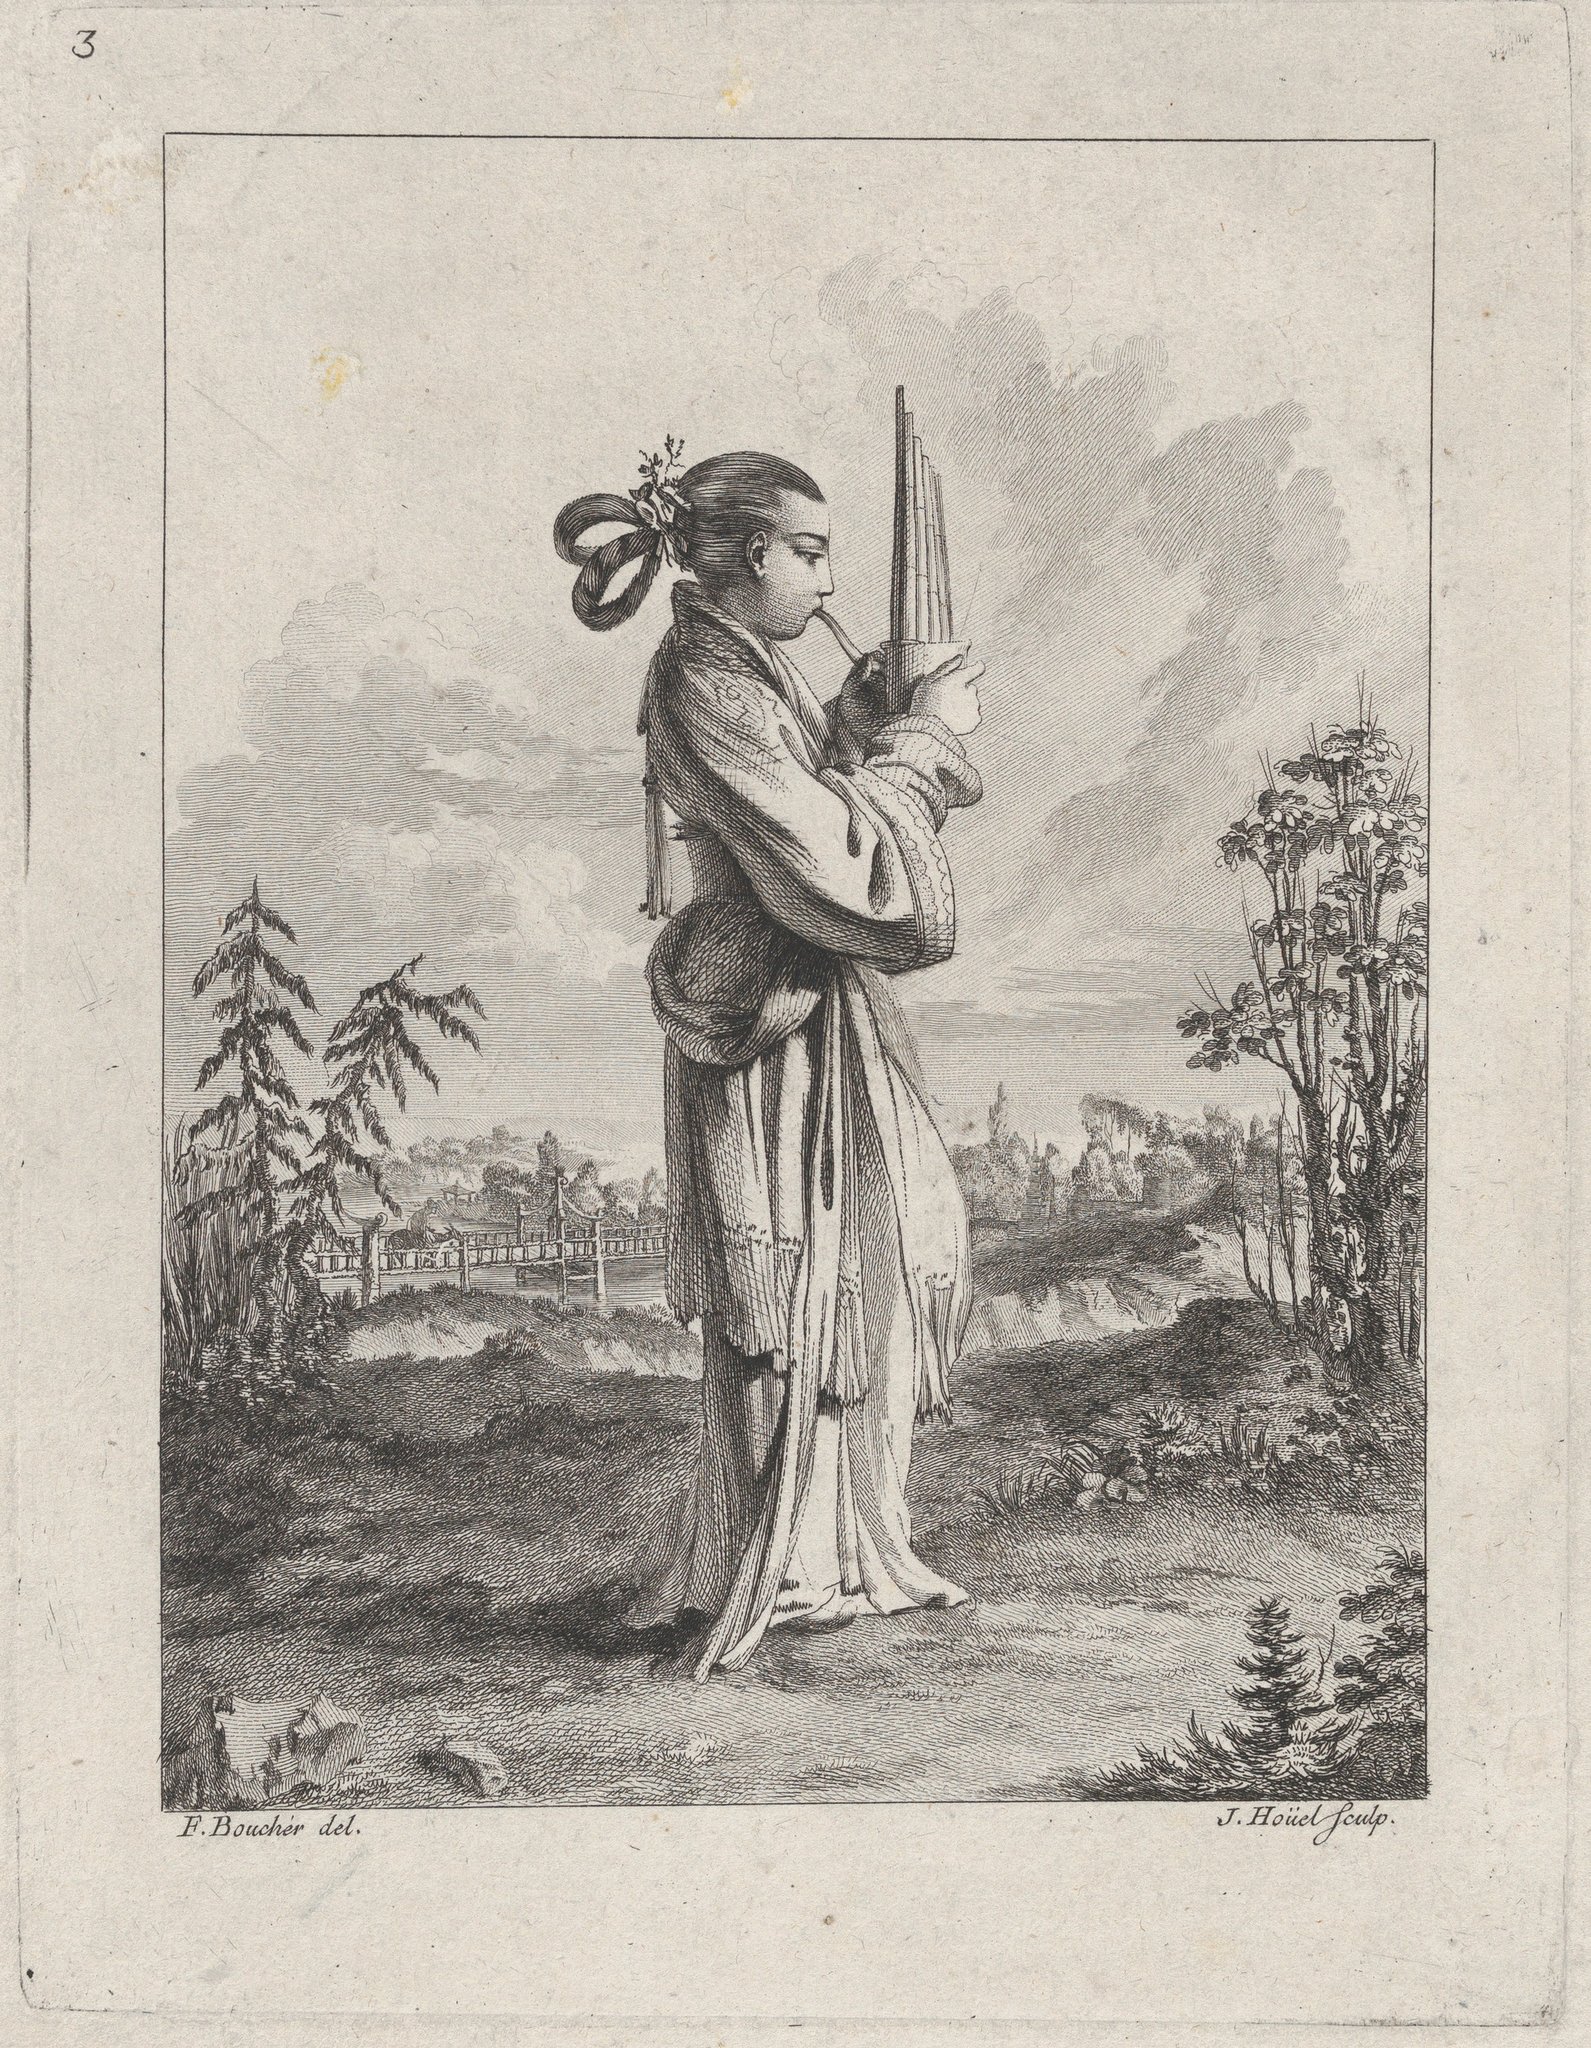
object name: print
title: Chinoiserie with a woman playing the mouth organ, from Suite de Figures Chinoises. . .Tiré du Cabinet de Mr. d'Azaincourt (Series of Chinoiserie Figures. . .From the Chambers of Mr. d'Azaincourt), plate 3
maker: jean pierre louis laurent hoüel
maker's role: artist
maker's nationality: french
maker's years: 1735-1813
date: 1755-1776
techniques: engraving, etching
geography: france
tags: musical instruments,chinoiserie,women